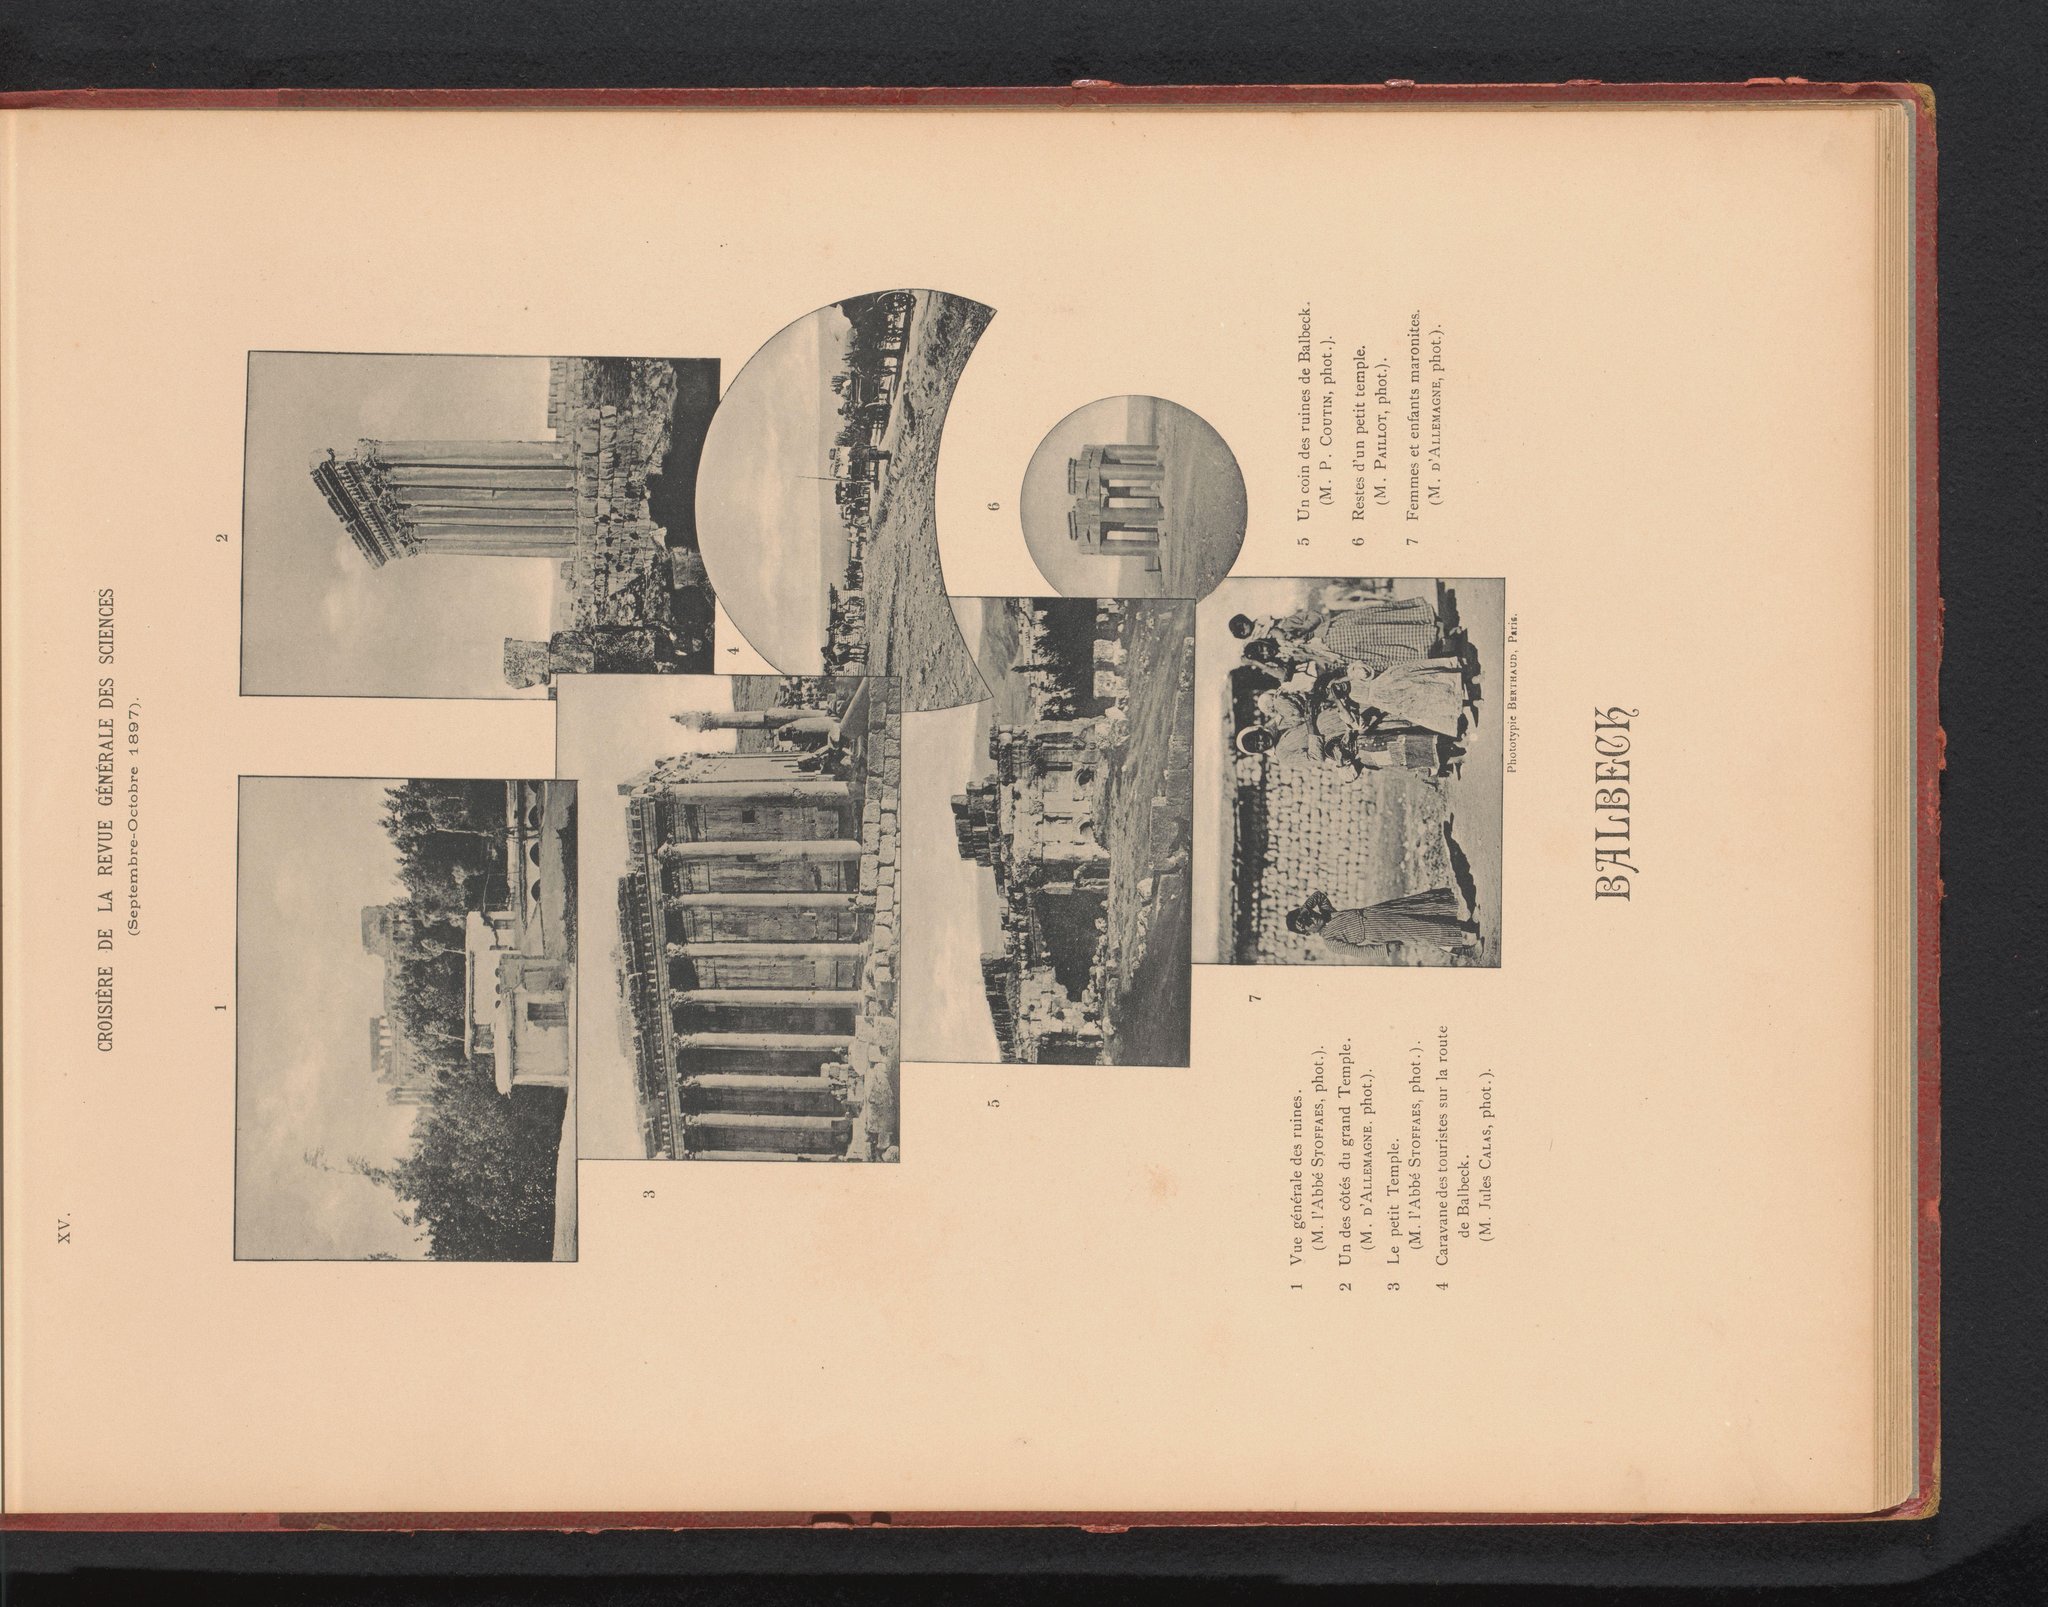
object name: photomechanical print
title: Zeven gezichten op Baalbek, Libanon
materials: paper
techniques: photograph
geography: baalbek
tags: city-view in general; 'veduta', ruin of a building ~ architecture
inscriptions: inscription: ‘1 Vue générale des ruines./ (M. l'Abbé Stoofaes, phot.)./ 2 Un des Côtés du grand Temple./ (M. d'Allemagne, phot.)./ 3 Le petit Temple./ (M. l'Abbé Stoffaes, phot.)./ 4 Caravane des touristes sur la route/ de Balbeck./ (M. Jules Calas, phot.)./ 5 Un coin des ruines de Balbeck./ (M. P. Coutin, phot.)./ 6 Restes d'un petit temple./ (M. Paillot, phot.)./ 7 Femmes et enfants maronites./ (M. d'Allemagne, phot.).’, number: ‘XV.’